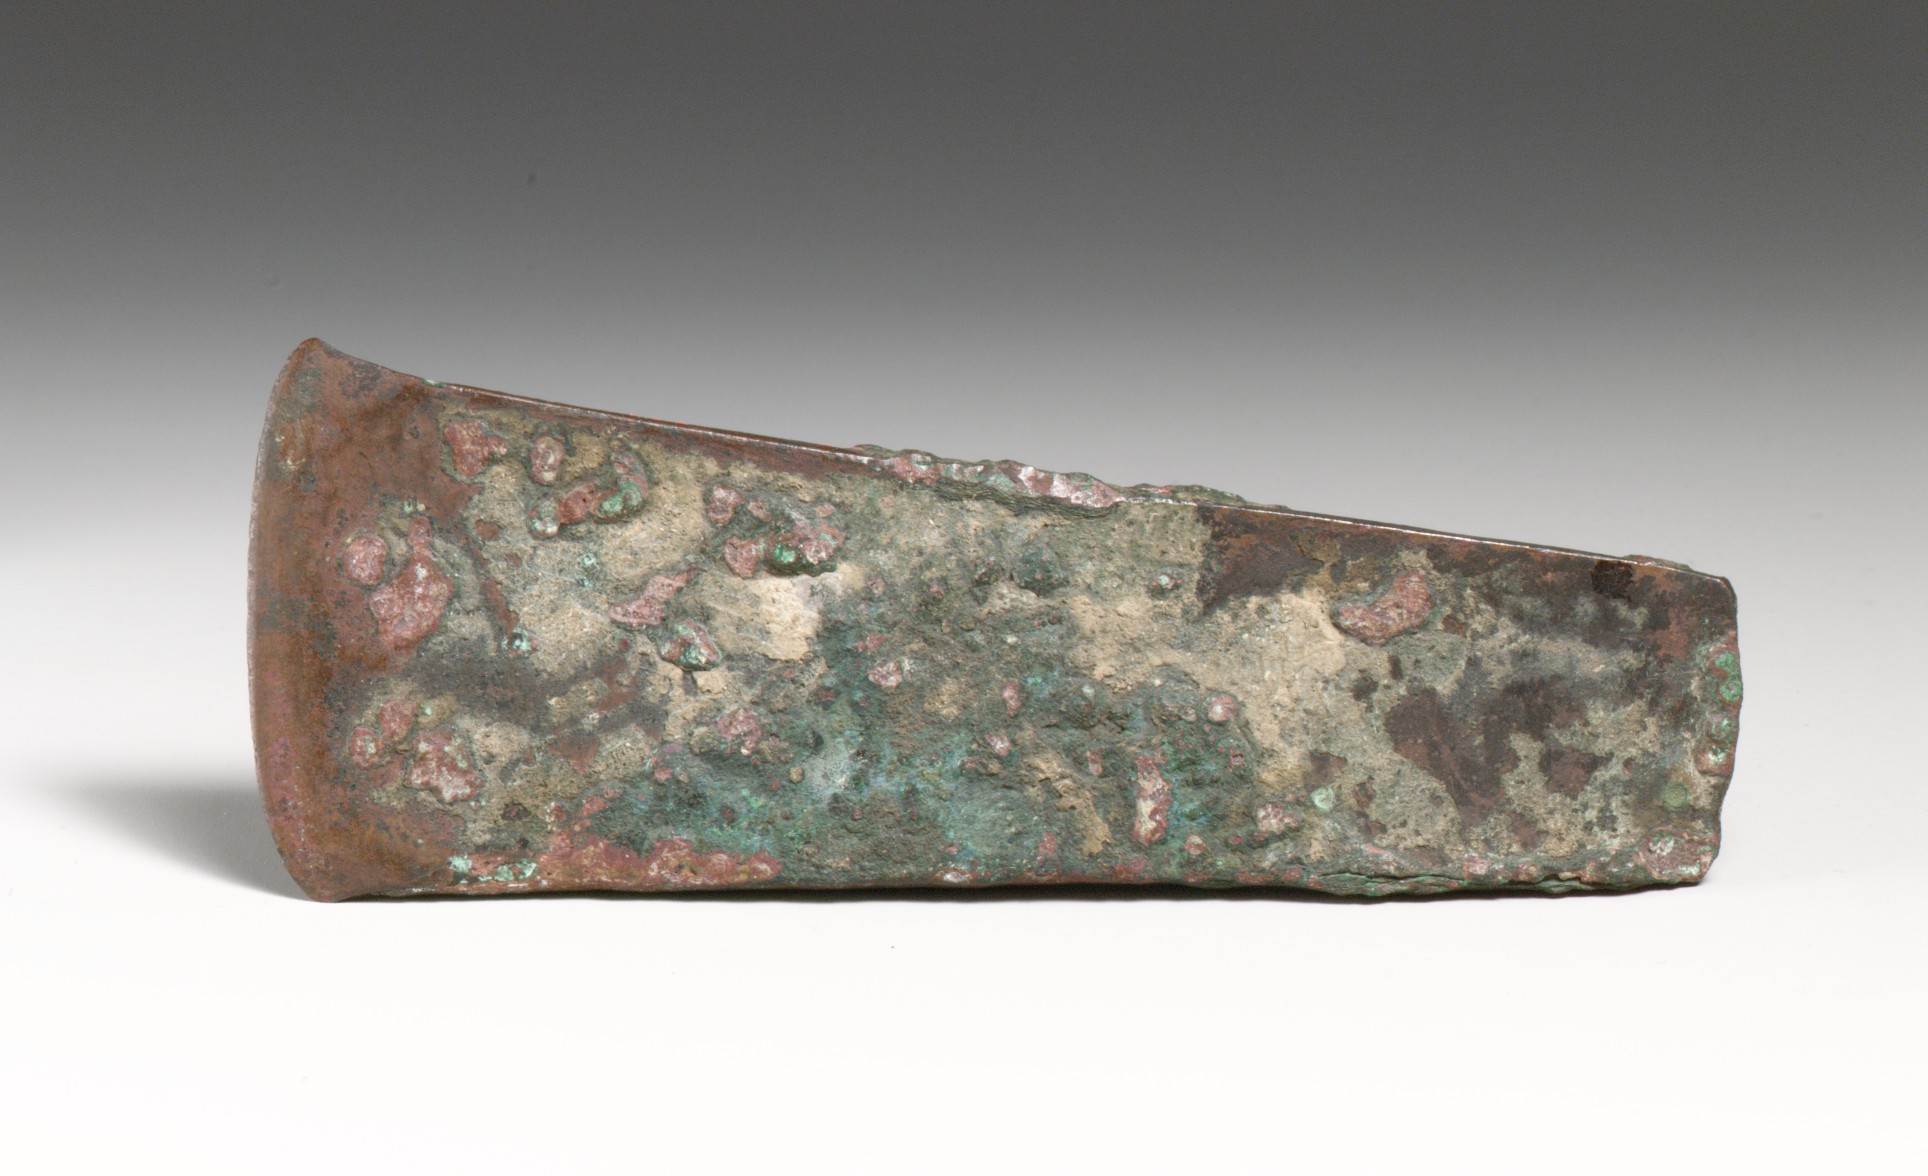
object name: axehead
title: Bronze axe head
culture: cypriot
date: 2500-1900 BCE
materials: bronze